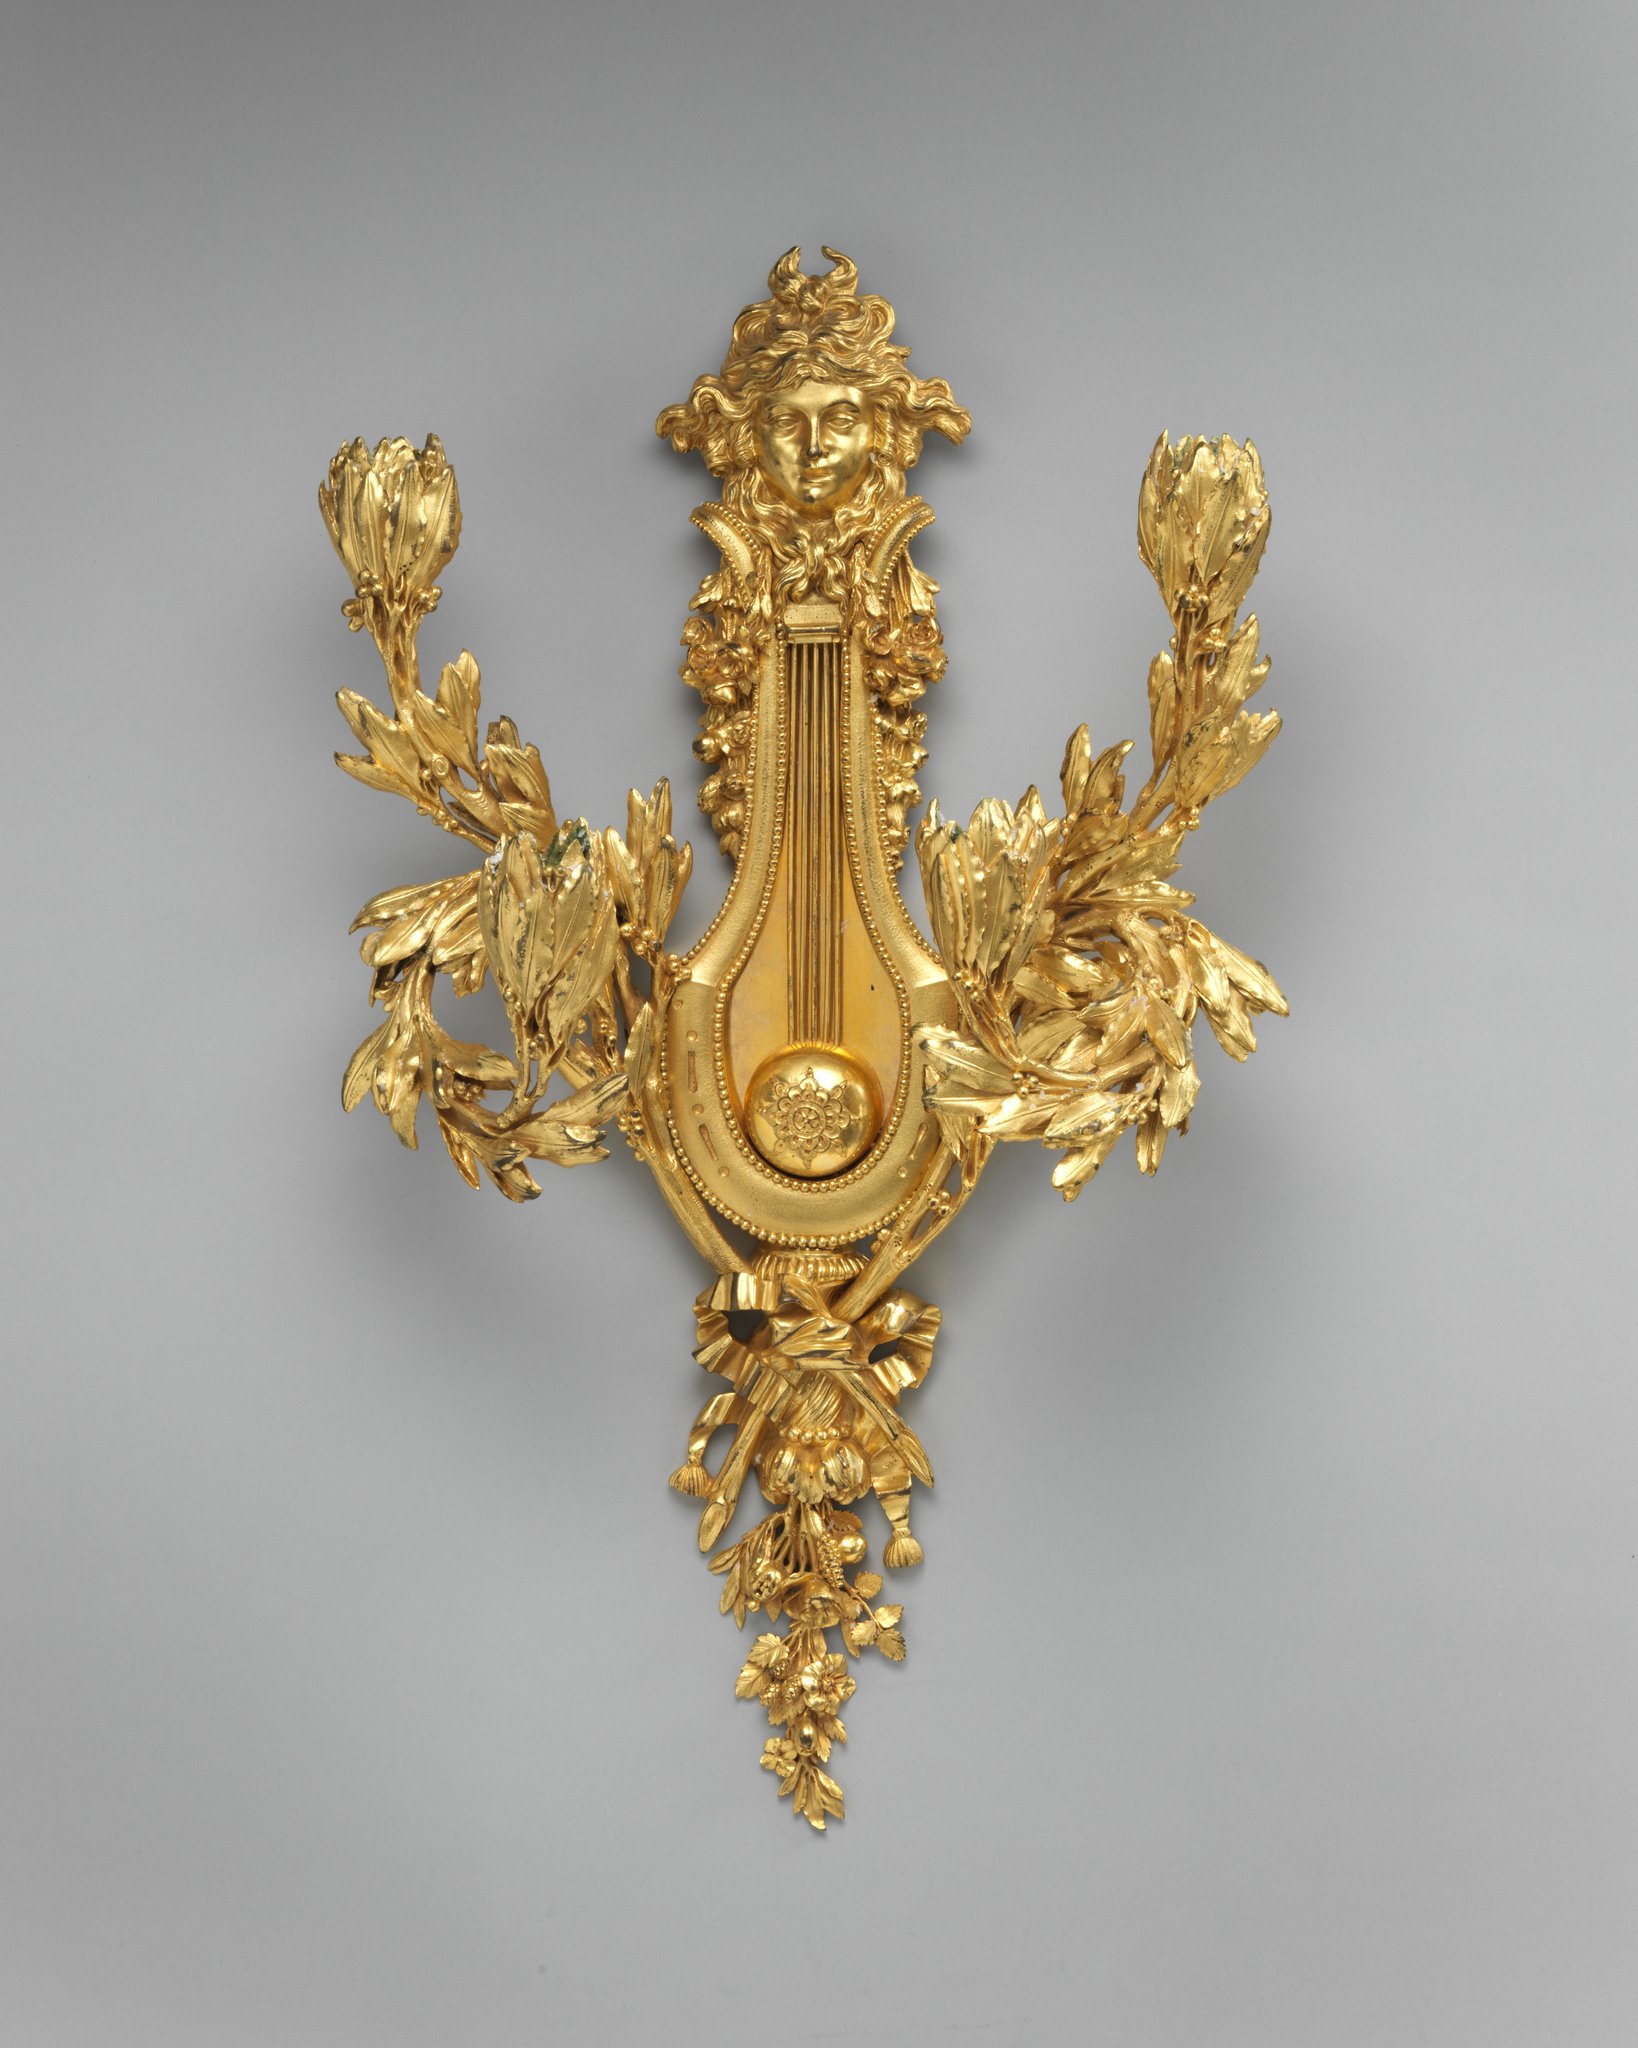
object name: wall light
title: Four-branched wall light in form of lyre (one of a set of four)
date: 1780-1789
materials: gilt bronze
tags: lyres